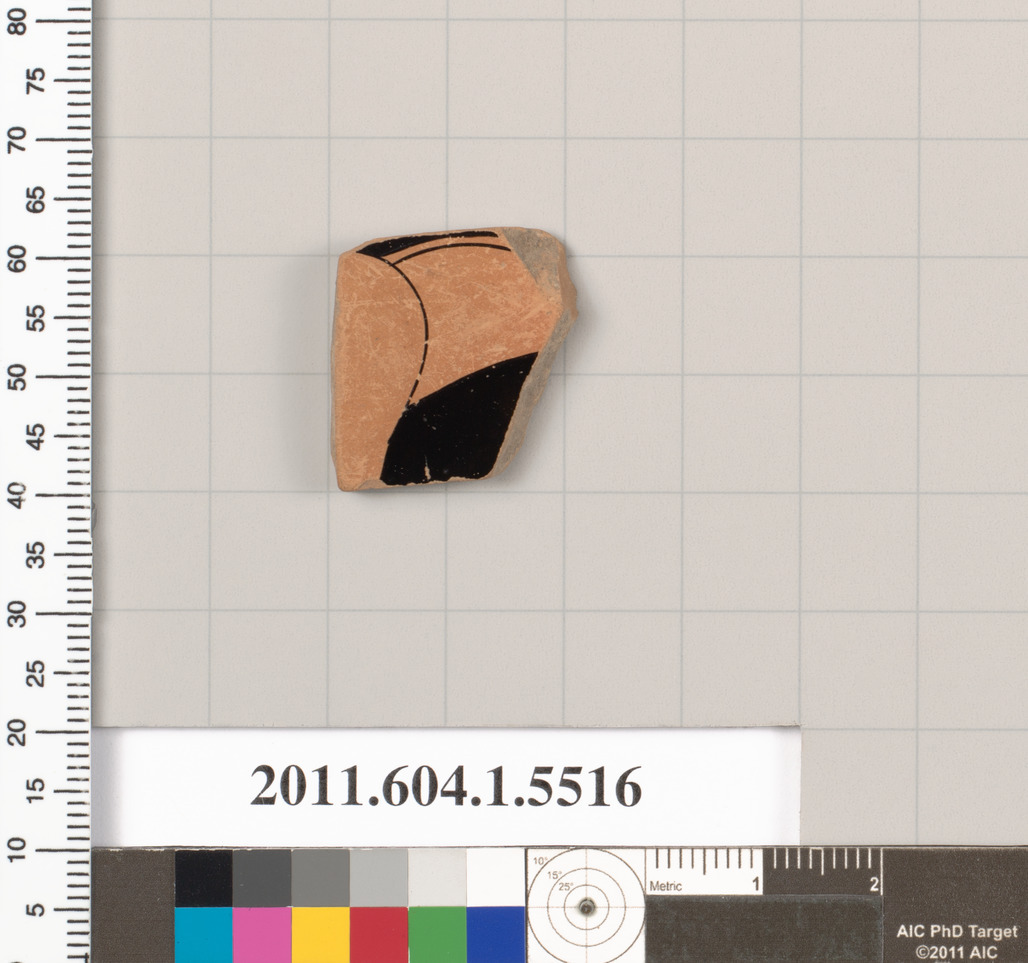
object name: kylix fragment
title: Terracotta fragment of a kylix (drinking cup)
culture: greek, attic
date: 510-490 BCE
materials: terracotta